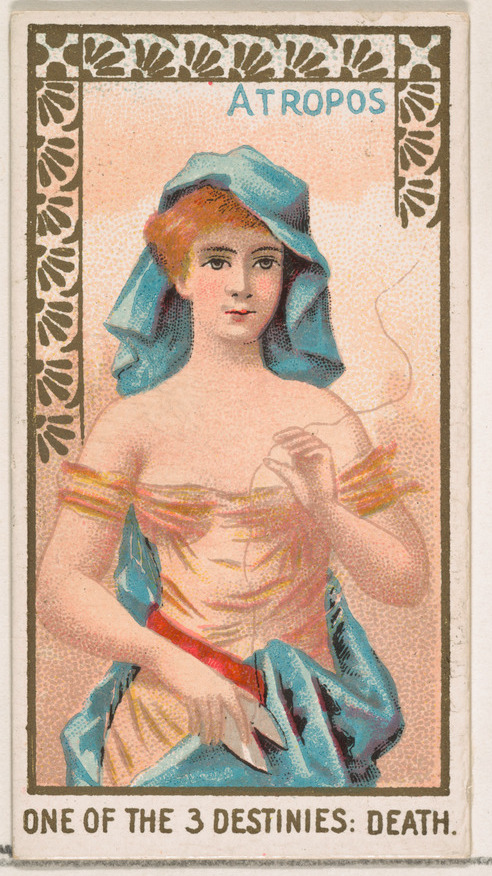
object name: print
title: Atropos, One of the Three Destinies, Death, from the Goddesses of the Greeks and Romans series (N188) issued by Wm. S. Kimball & Co.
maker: william s. kimball & company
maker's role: publisher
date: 1889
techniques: color lithograph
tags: women